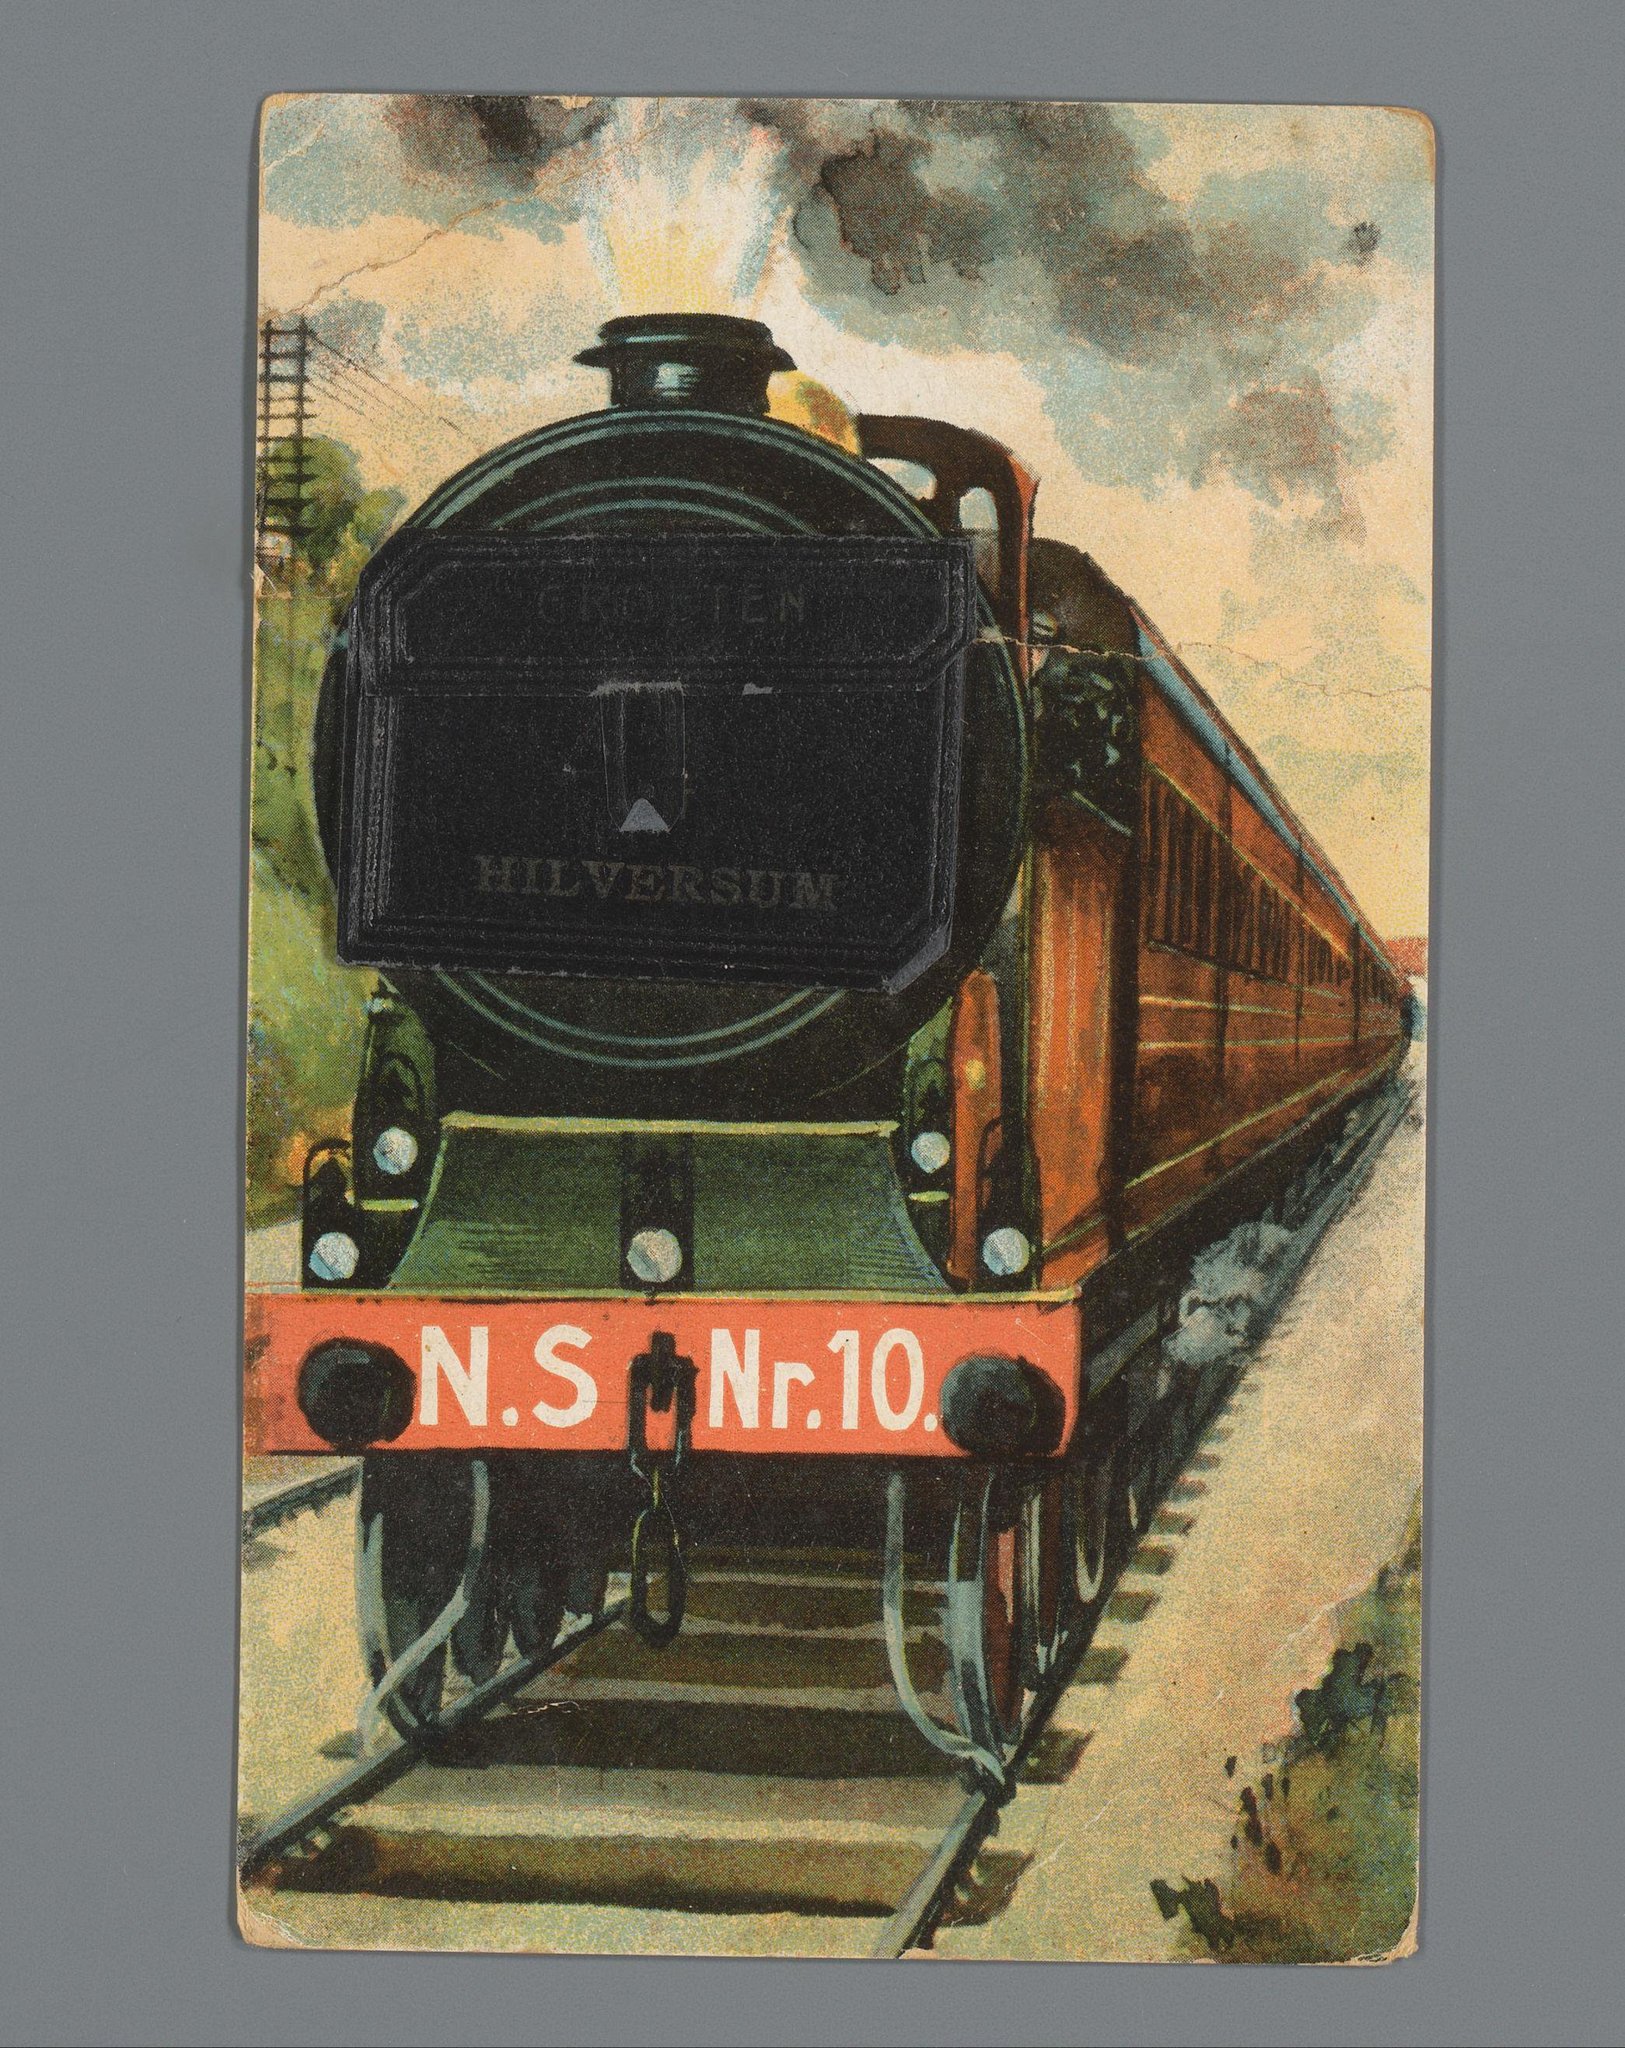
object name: ansichtkaart, prentbriefkaart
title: Reproductie van een stoomlocomotief, op de voorzijde een envelop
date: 1918-1944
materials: paper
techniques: lithograph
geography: hilversum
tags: letter, envelope, steam locomotive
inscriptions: inscription: ‘€6-’, inscription: ‘HILVERSUM’, inscription: ‘Tootje Sitters Welld. [?]’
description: Reproductie van een stoomlocomotief met op de voorzijde een envelop geplakt met daarin een leporello met tien gezichten op Hilversum.